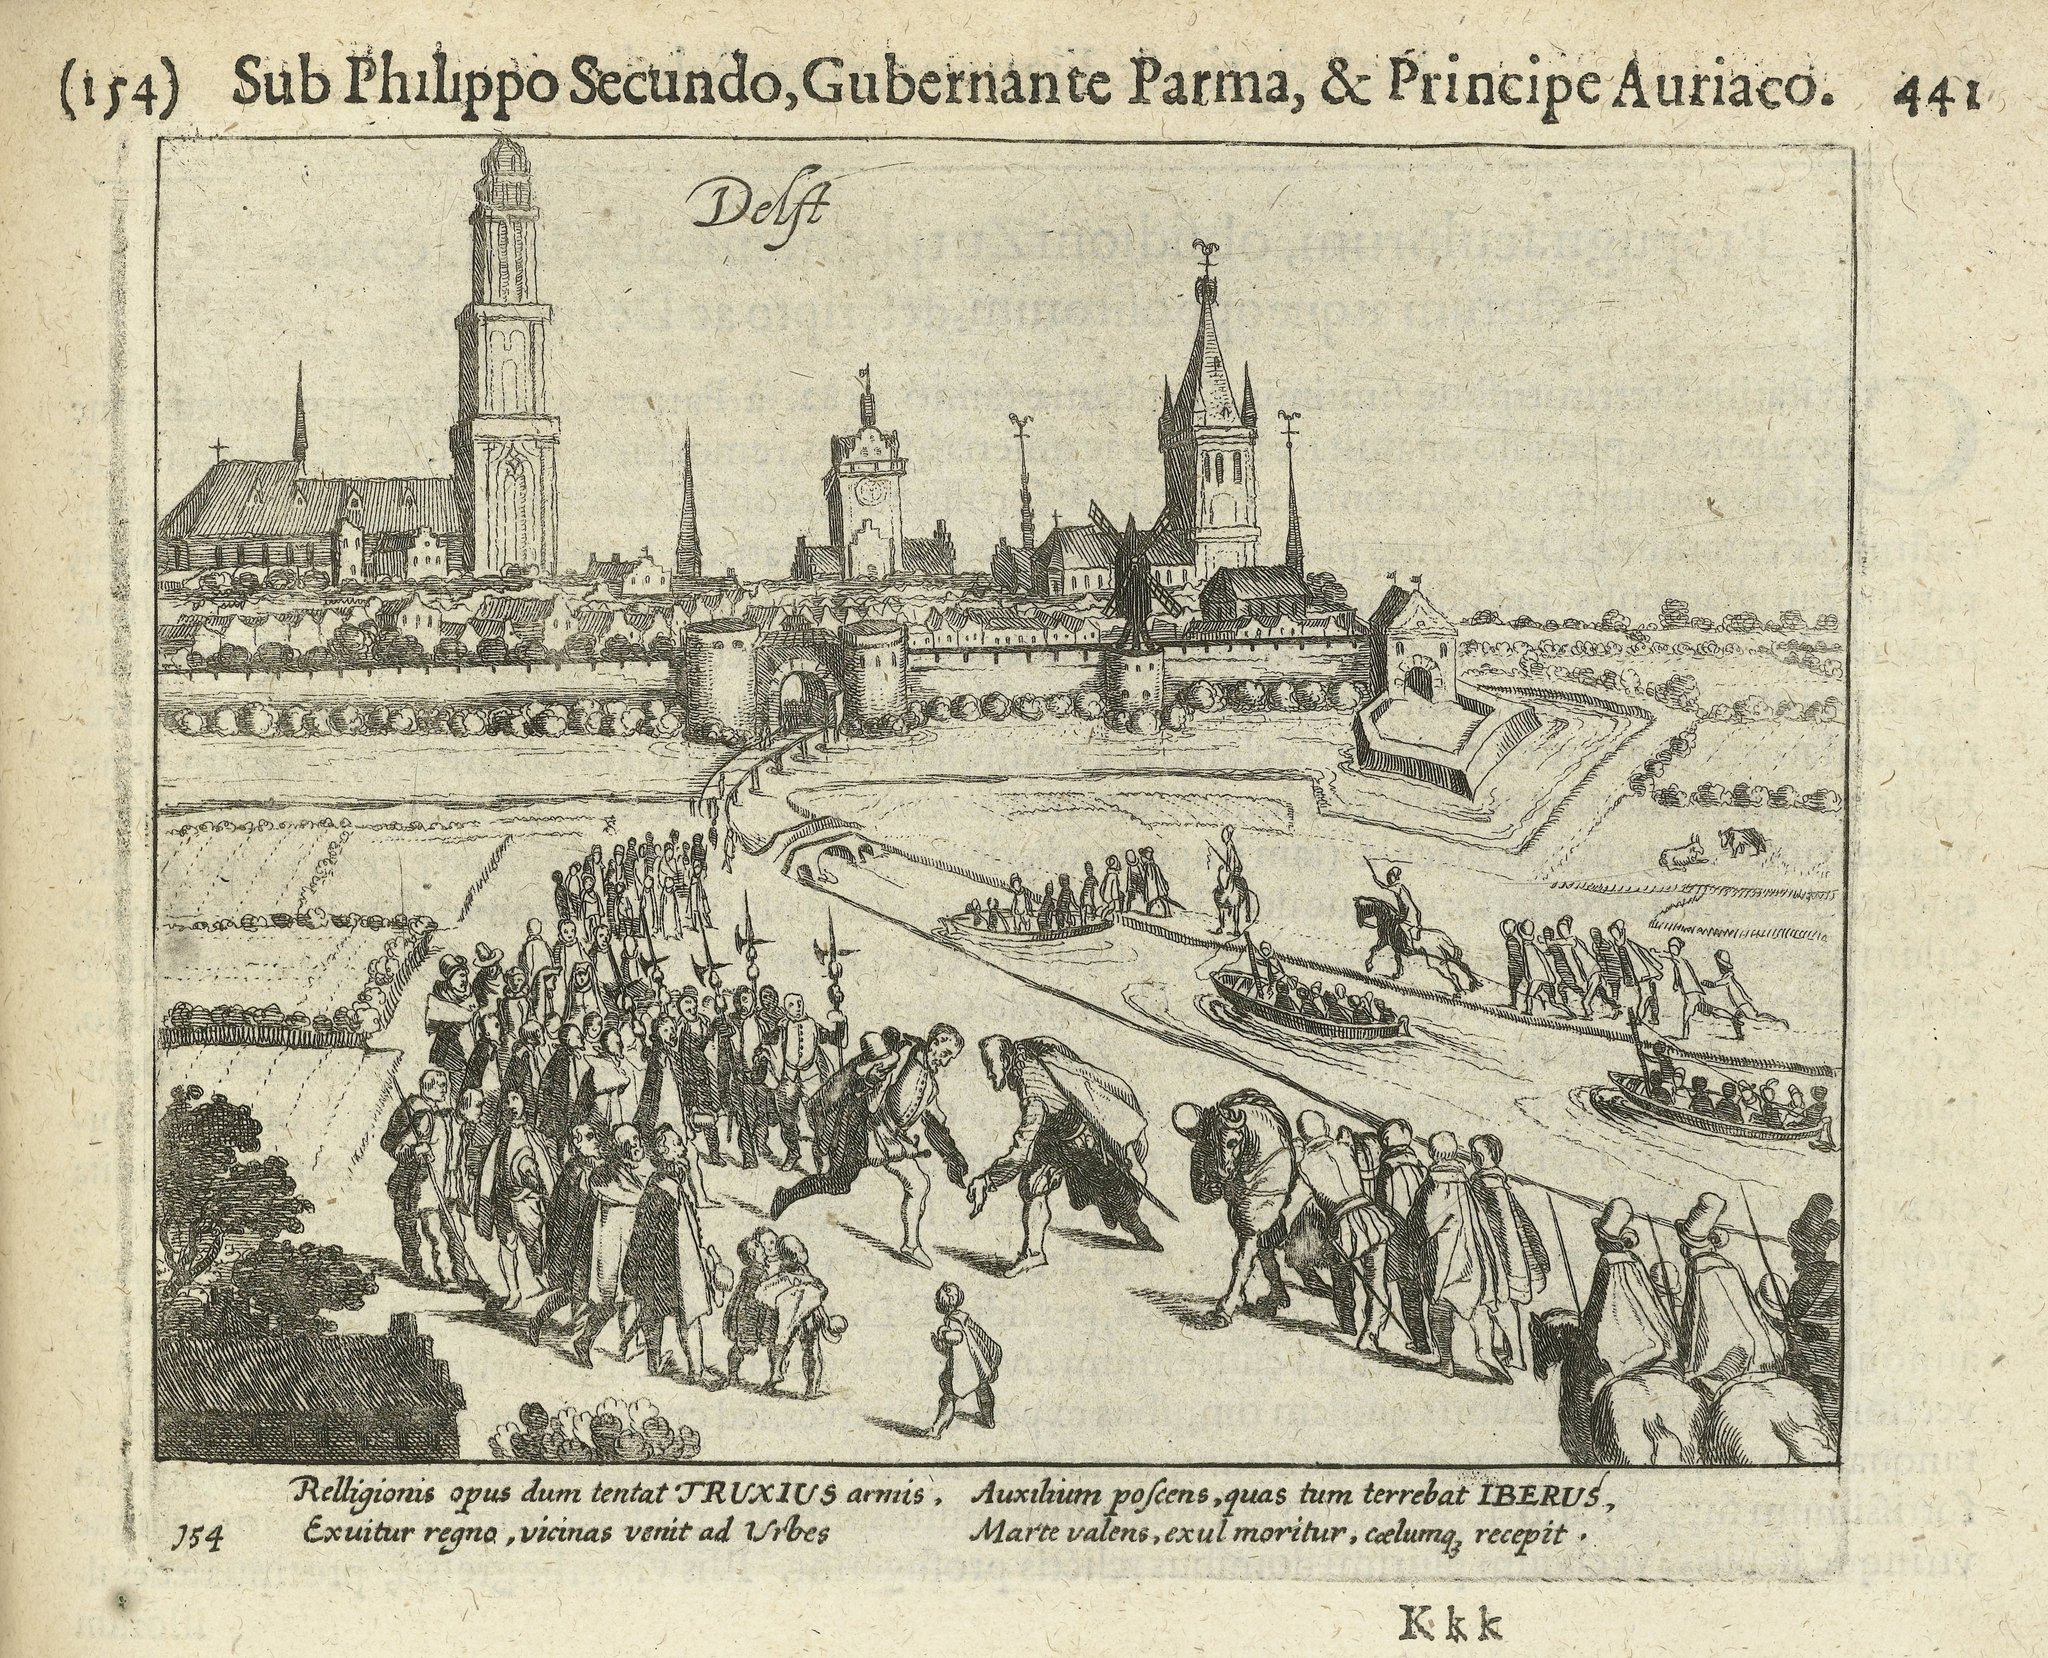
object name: print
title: Truchsess wordt te Delft ontvangen, 1584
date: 1613-1615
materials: paper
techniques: etching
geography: northern netherlands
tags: siege, position war, delft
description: Gebhard Truchsess, bisschop van Keulen, wordt te Delft statelijk ontvangen, 20 april 1584. Een delegatie van de stad ontmoet de bisschop buiten de stad. Episode uit de Keulse Oorlog. Met onderschrift van 4 regels in het Latijn. Genummerd 154. Bedrukt op achterzijde met tekst in het Latijn.